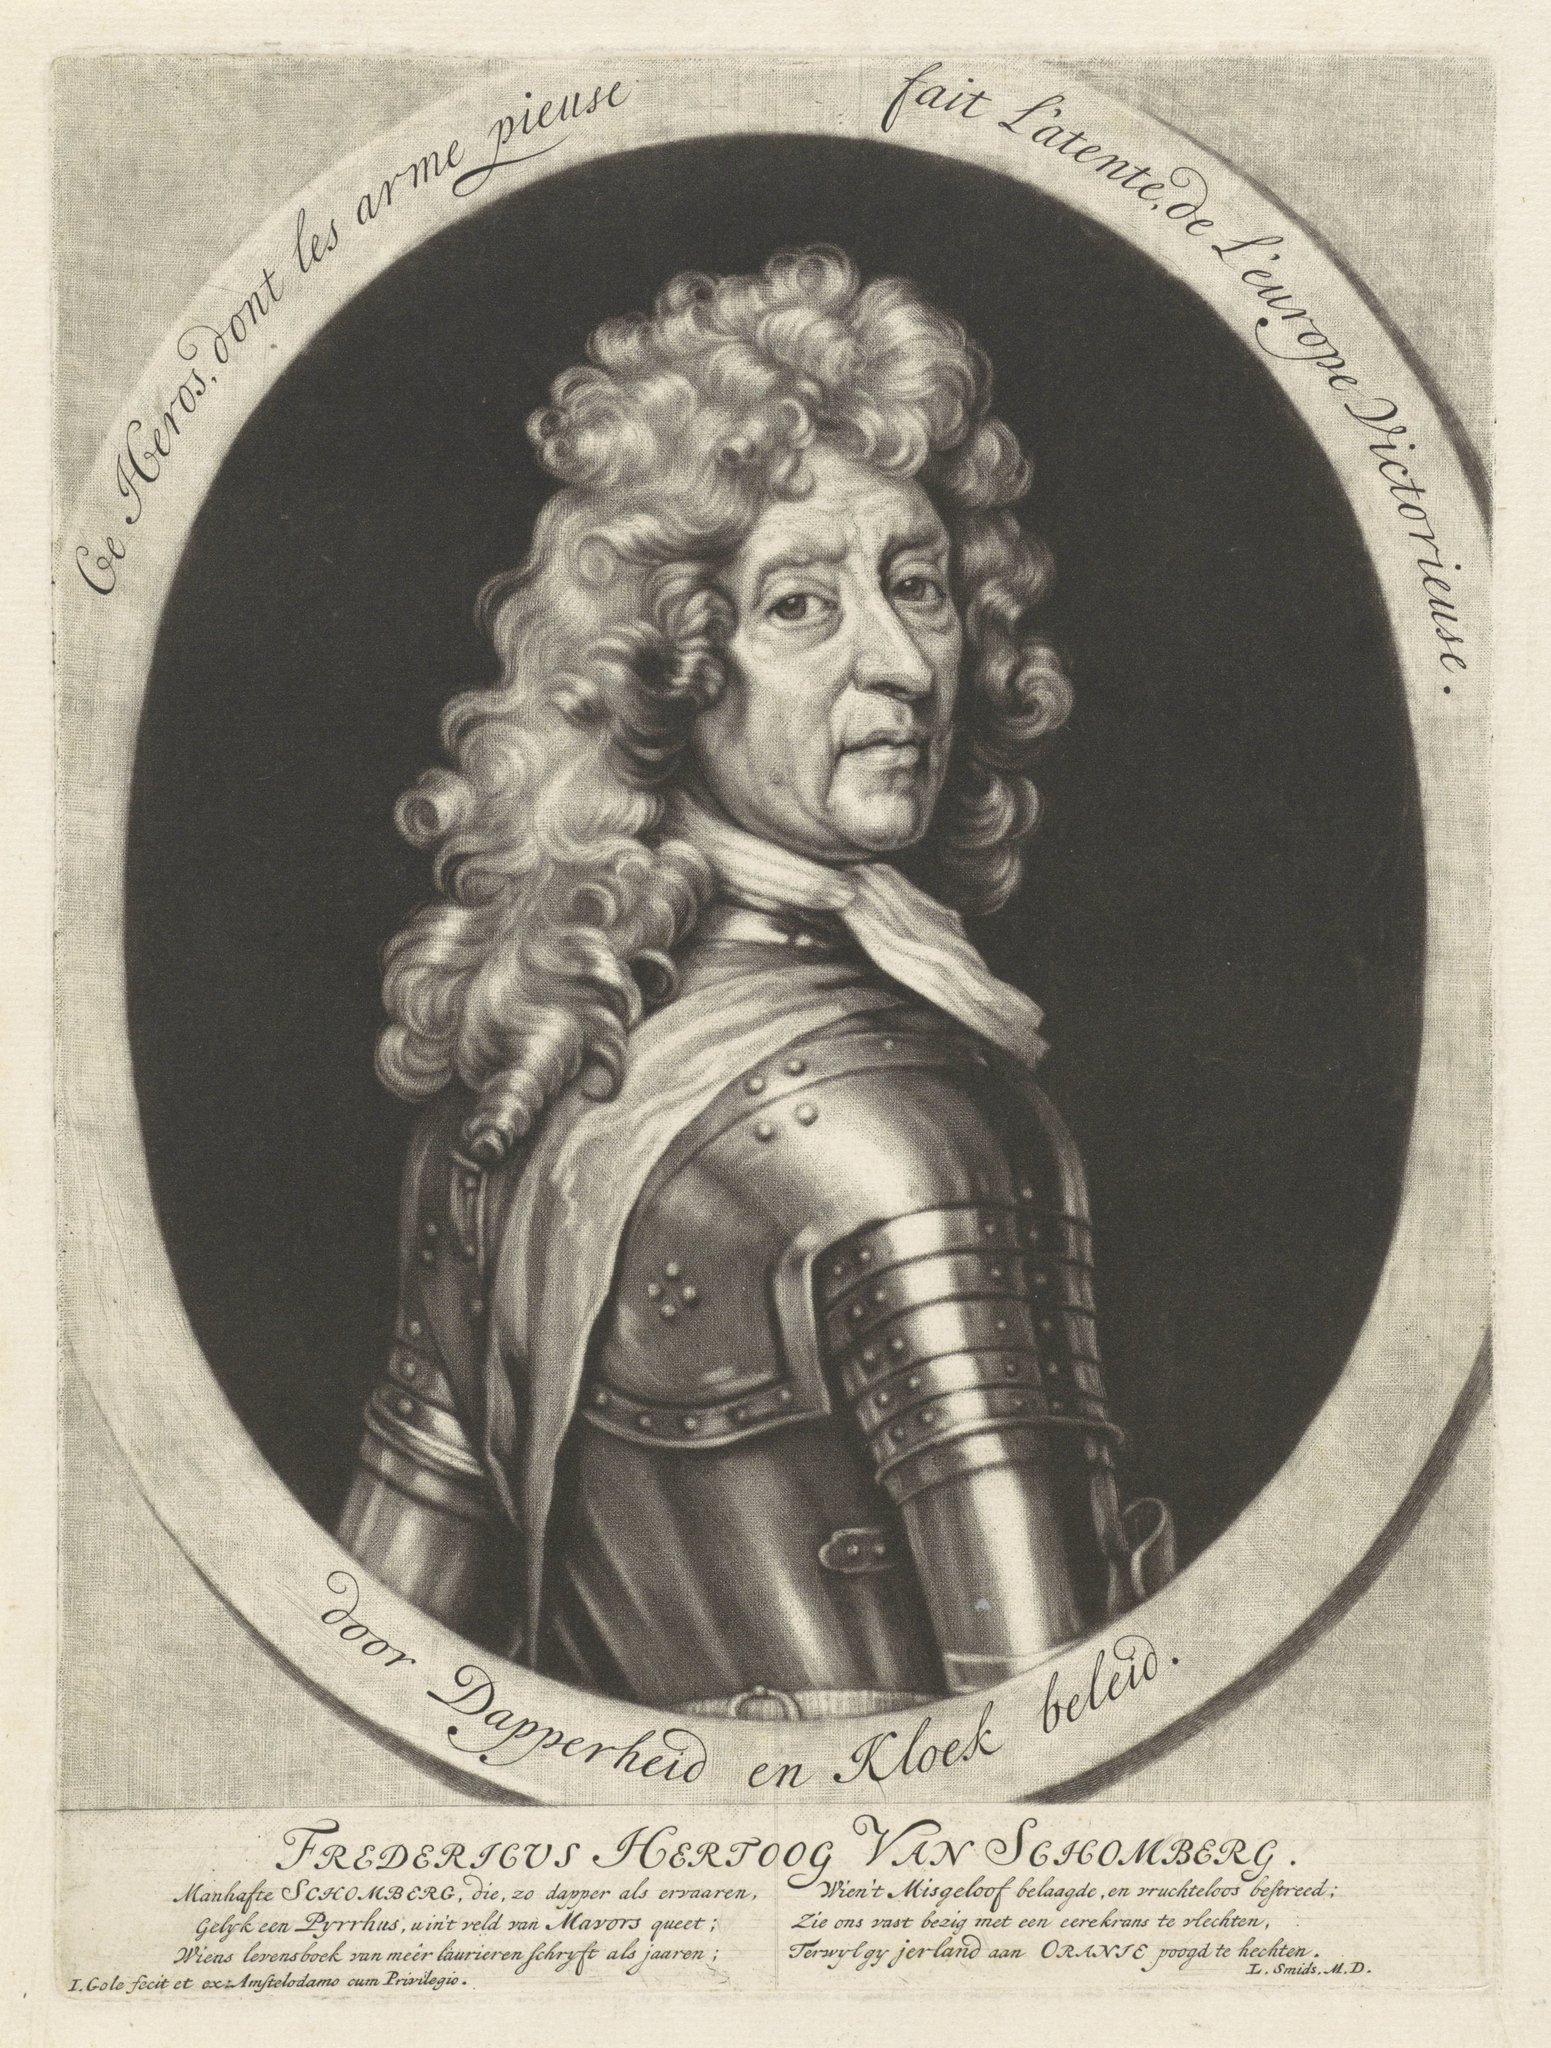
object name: print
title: Portret van Friedrich Arnaud hertog van Schomberg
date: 1670-1724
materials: paper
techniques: engraving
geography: amsterdam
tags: harness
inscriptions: collector's mark: Lugt 2228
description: De veldheer Friedrich Arnaud hertog van Schomberg. Hij draagt een harnas. In de marge een lofdicht op zijn dapperheid.